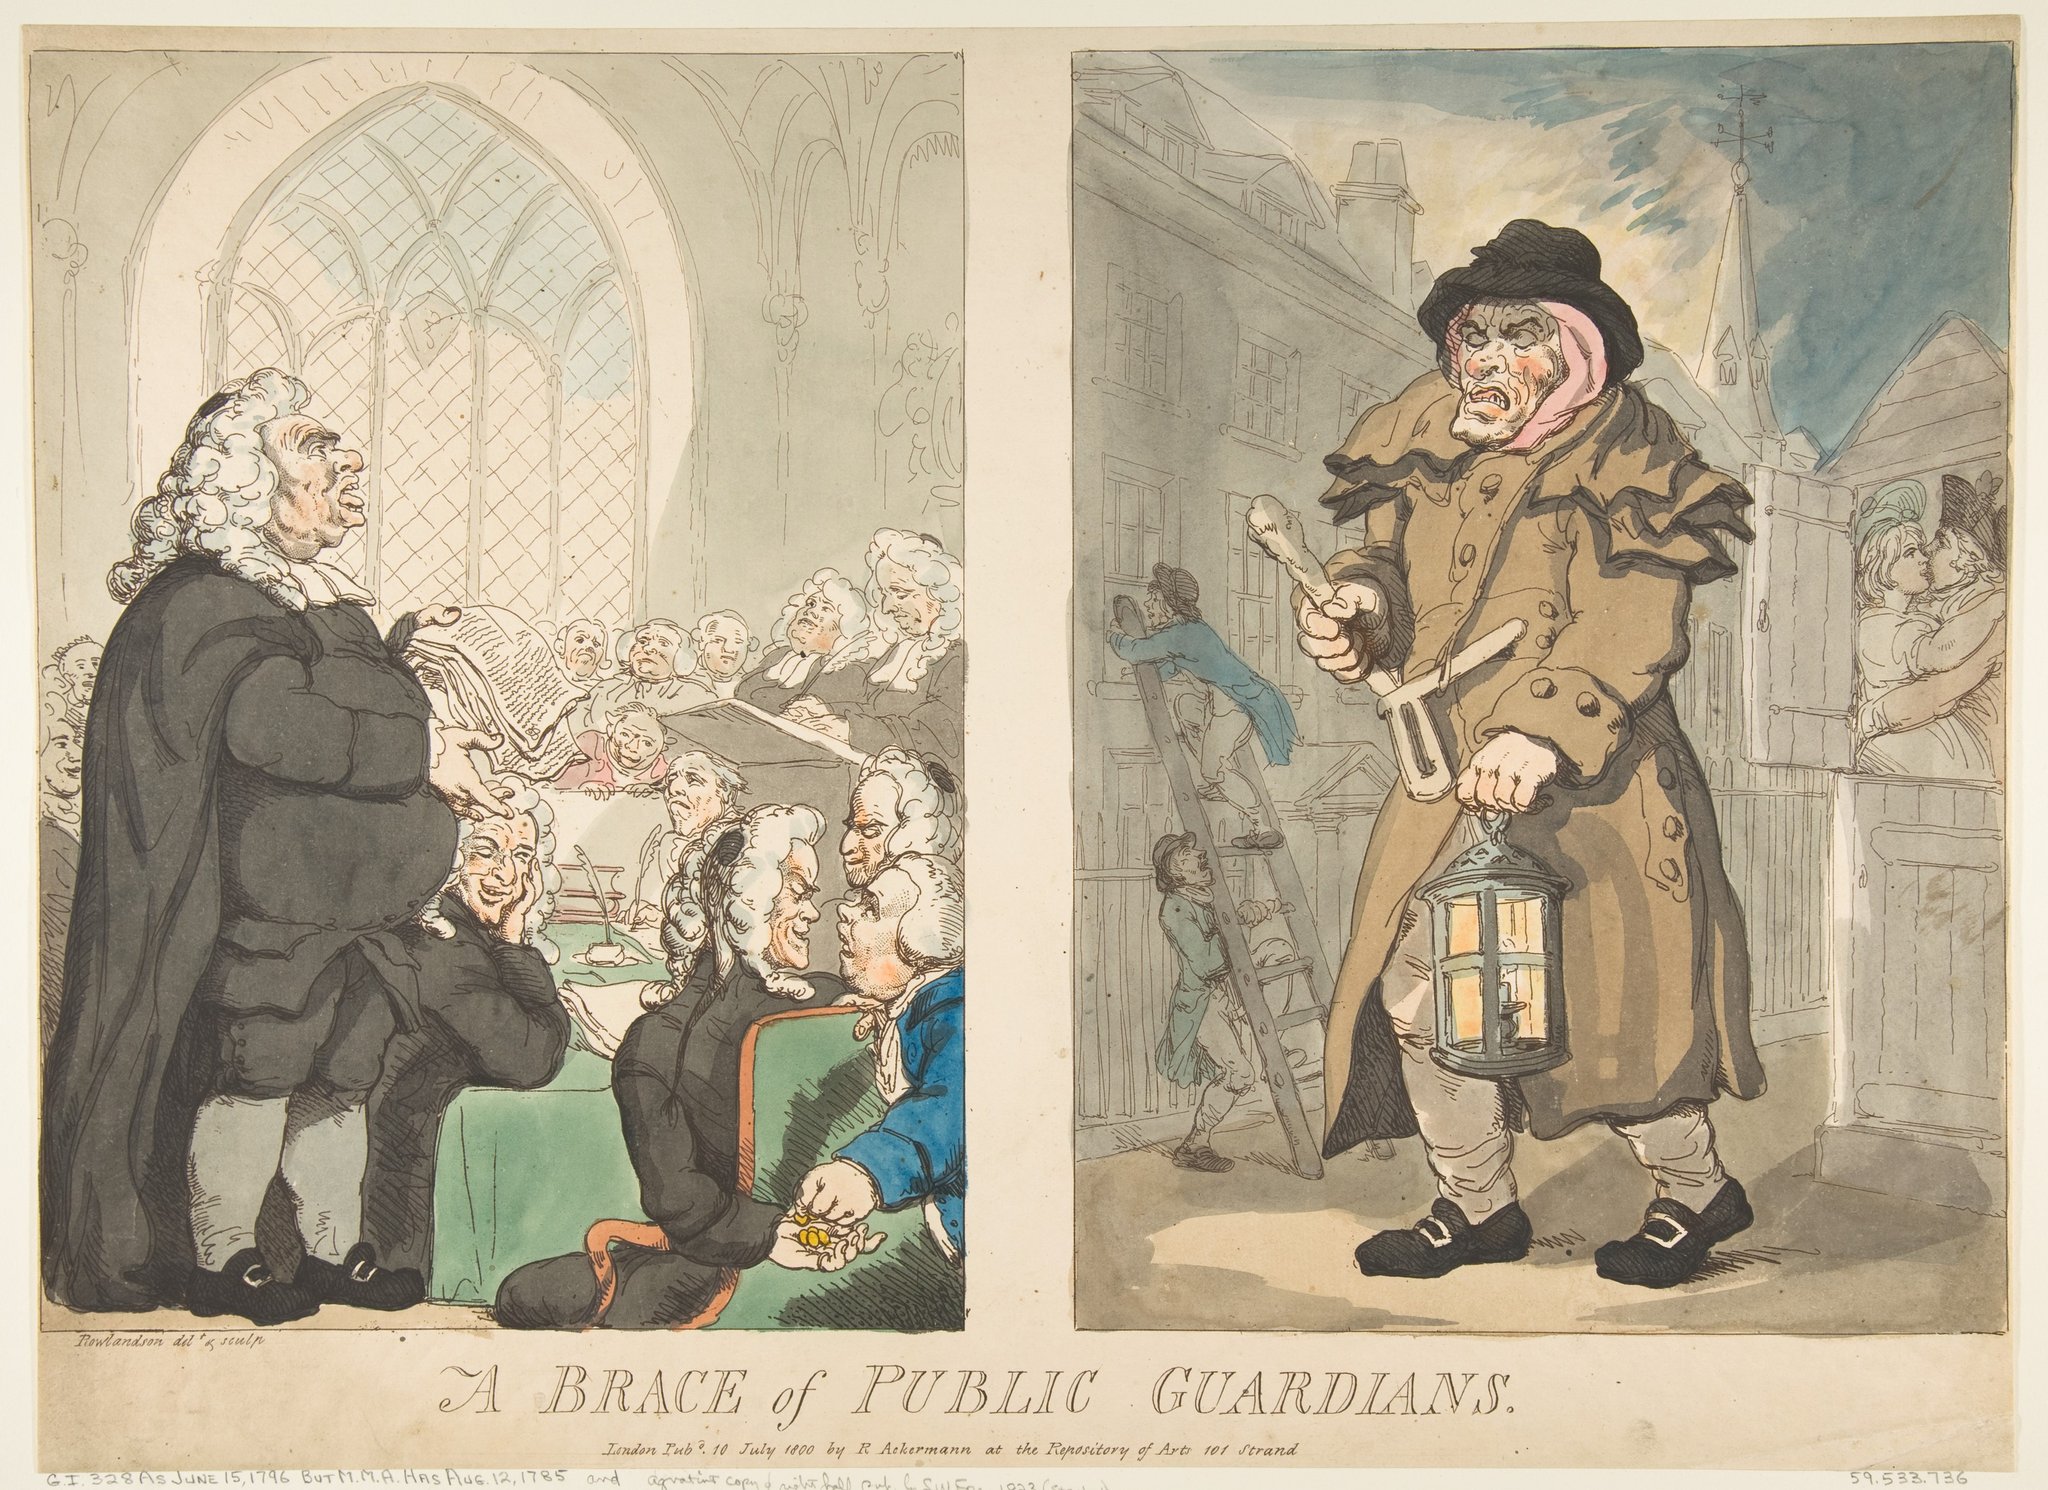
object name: print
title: A Brace of Public Guardians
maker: thomas rowlandson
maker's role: artist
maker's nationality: british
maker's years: 1757-1827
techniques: etching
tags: satire,men